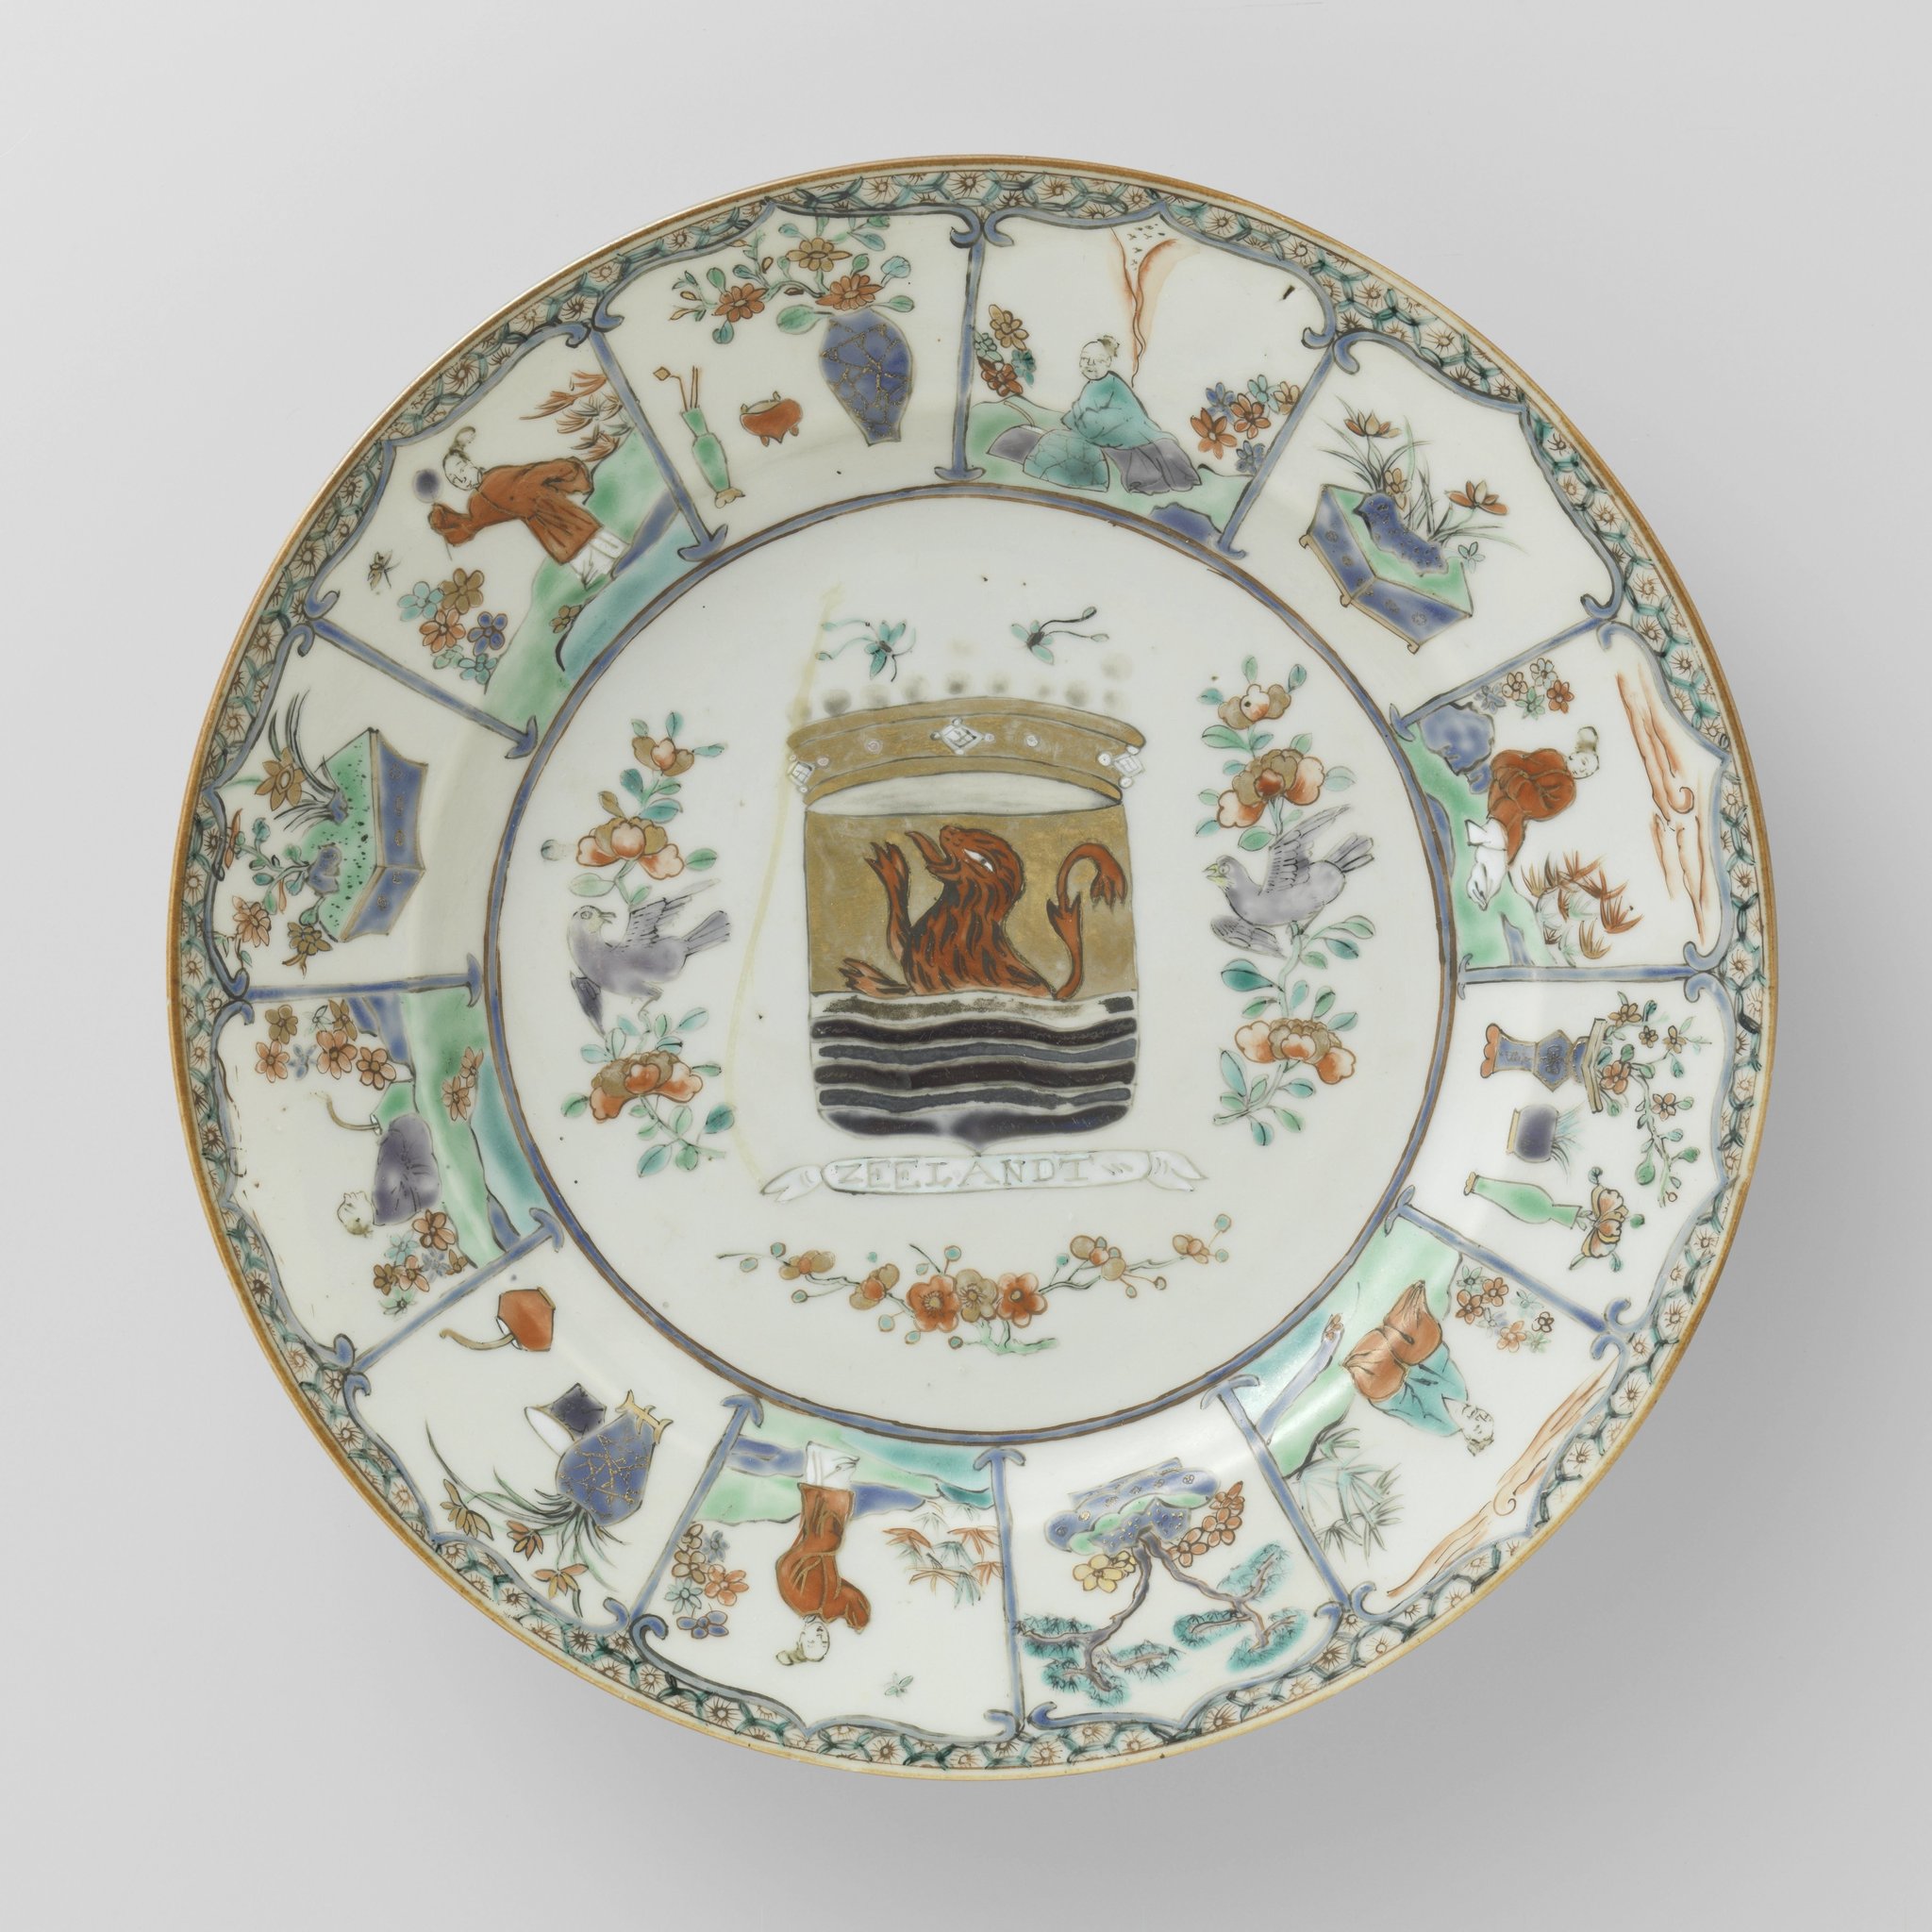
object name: platter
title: Plate with the arms of the province of Zeeland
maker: Anonymous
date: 1700-1724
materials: glaze, gold, paint, porcelain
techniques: firing, gilding, turning, vitrification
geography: china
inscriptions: inscription: ‘ZEELANDT’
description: Schotel van porselein, 'Chine de Commande'. Beschilderd in 'famille verte' kleuren. In het plat het wapen van Zeeland, met daaronder het woord Zeelandt, omgeven door bloemtakken met vogels en vlinders. De rand is verdeeld in 12 versierde vakken.